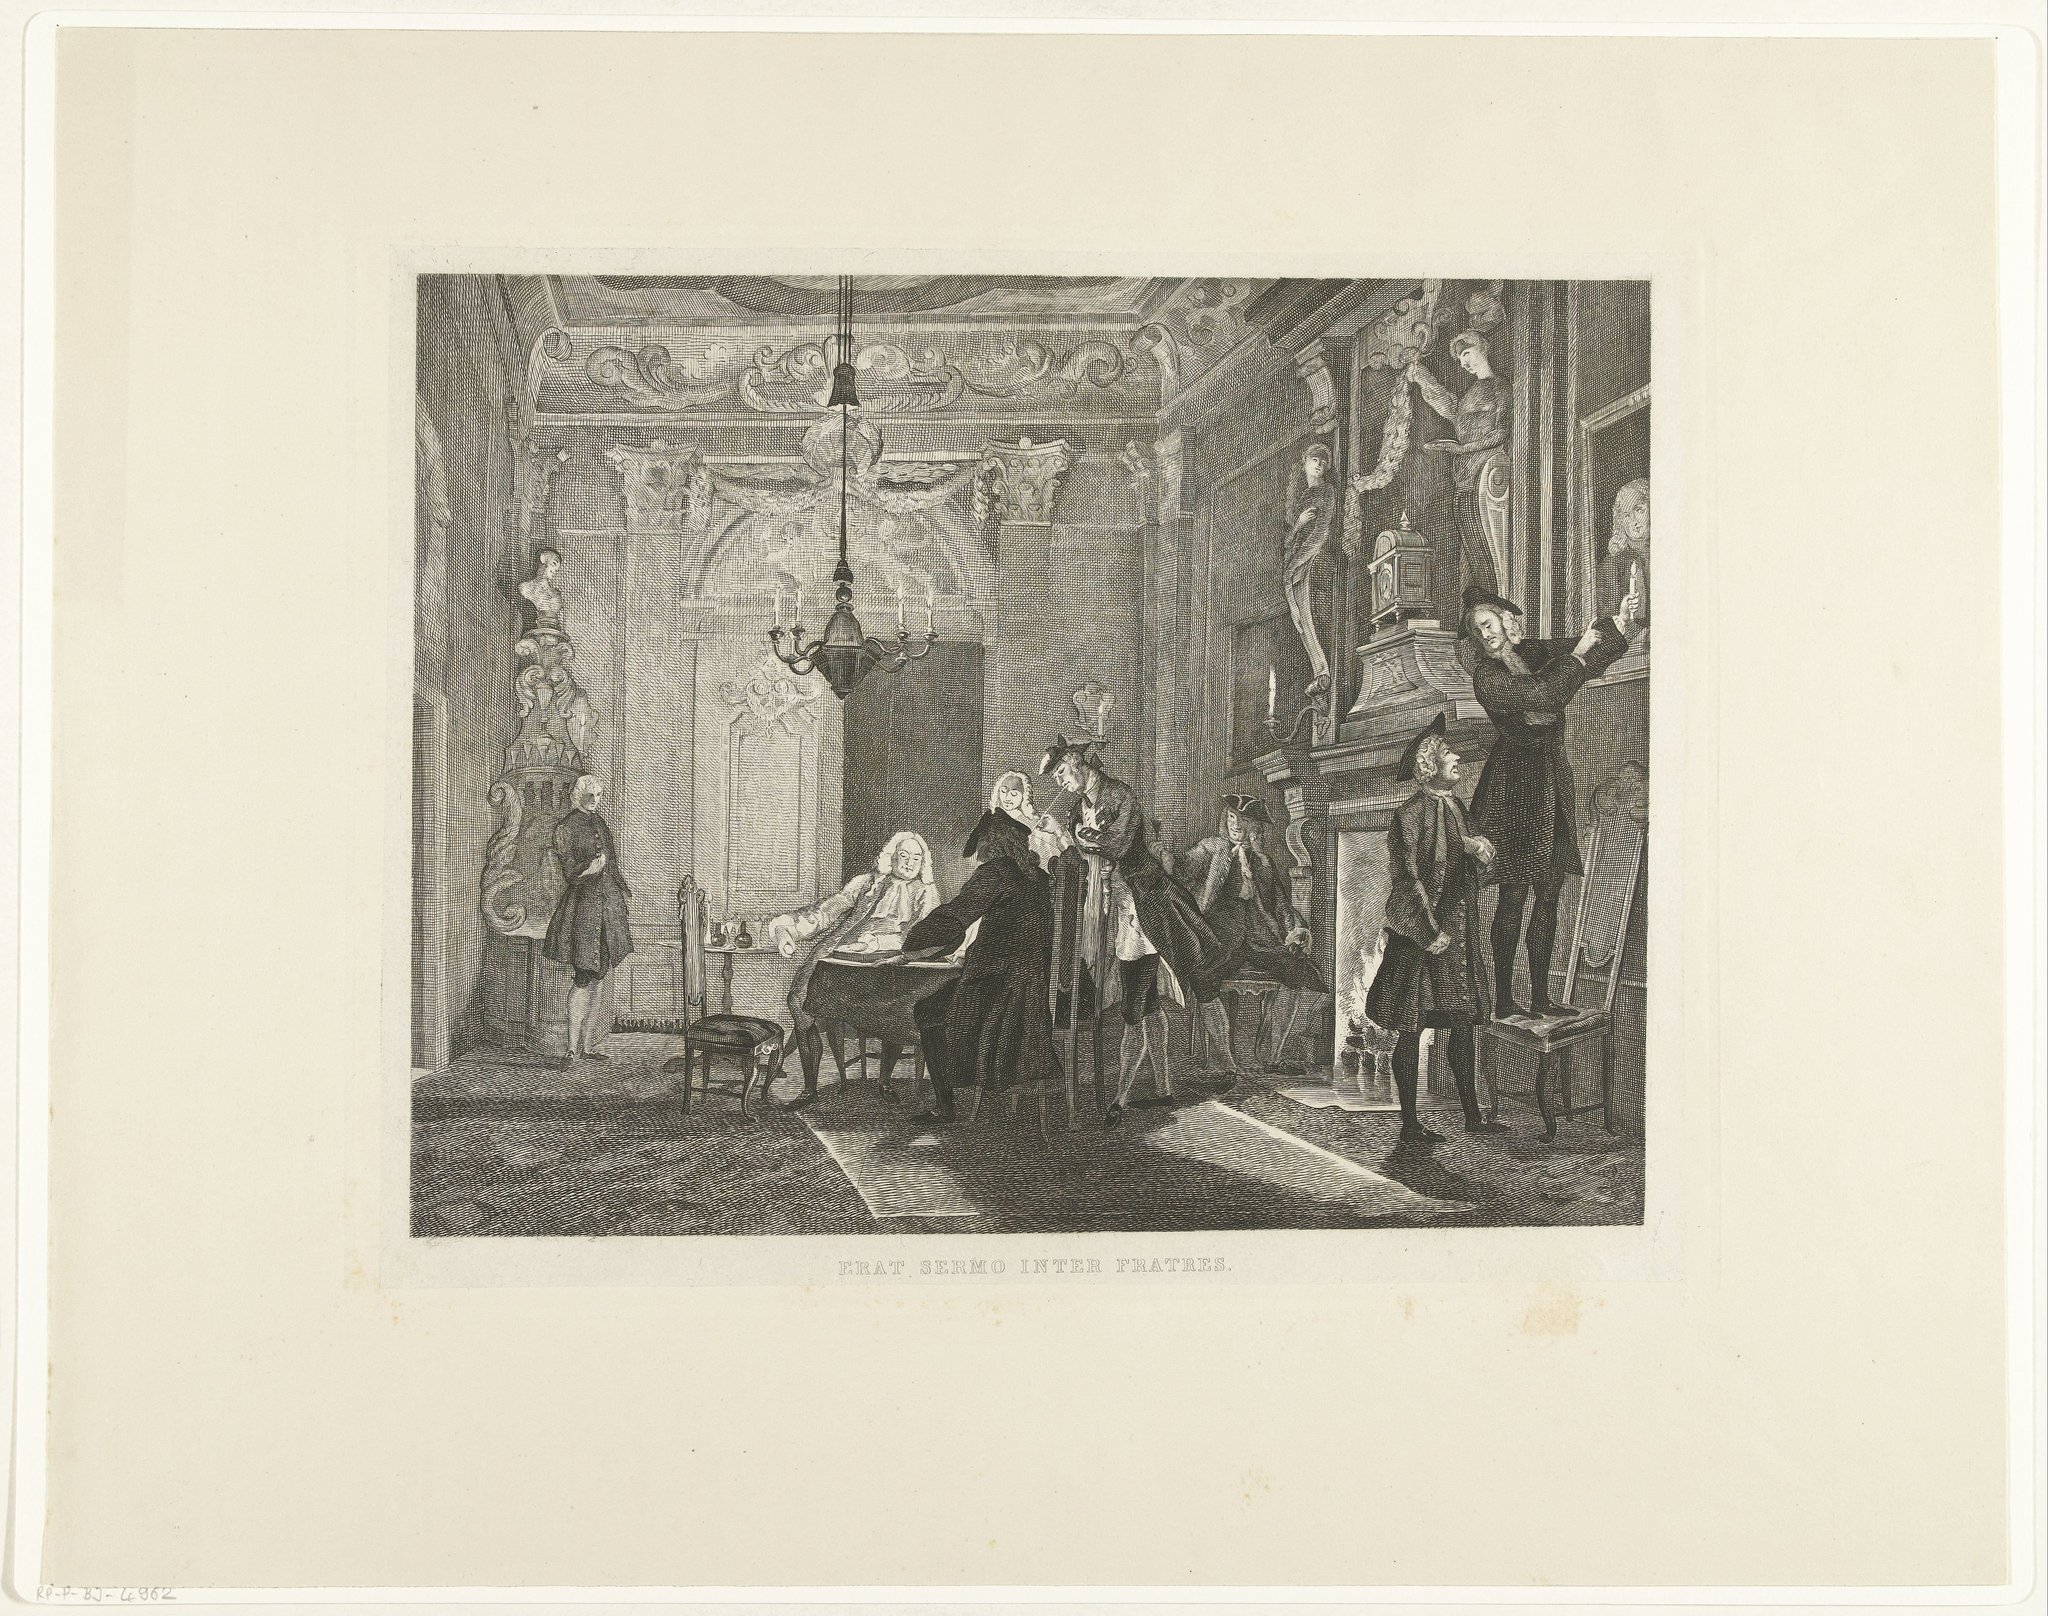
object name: print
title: Nelri naar Cornelis Troost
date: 1850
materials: paper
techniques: etching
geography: leiden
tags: drawing-room, 'salon', drinks, stimulants, drugs (+ taking (particular) foodstuffs: eating, drinking, smoking, chewing, etc.), board-games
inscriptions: collector's mark: Lugt 2165, collector's mark: Lugt 2228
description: Een groep heren is bijeen in een rooksalon. Twee mannen spelen een bordspel en twee anderen kijken toe. De klok boven de open haard staat op 8 uur. Rechts op de voorgrond staat een man op een stoel om een ander een detail op een schilderij aan te wijzen. Deel een van de serie 'Nelri' naar pastels van Cornelis Troost.